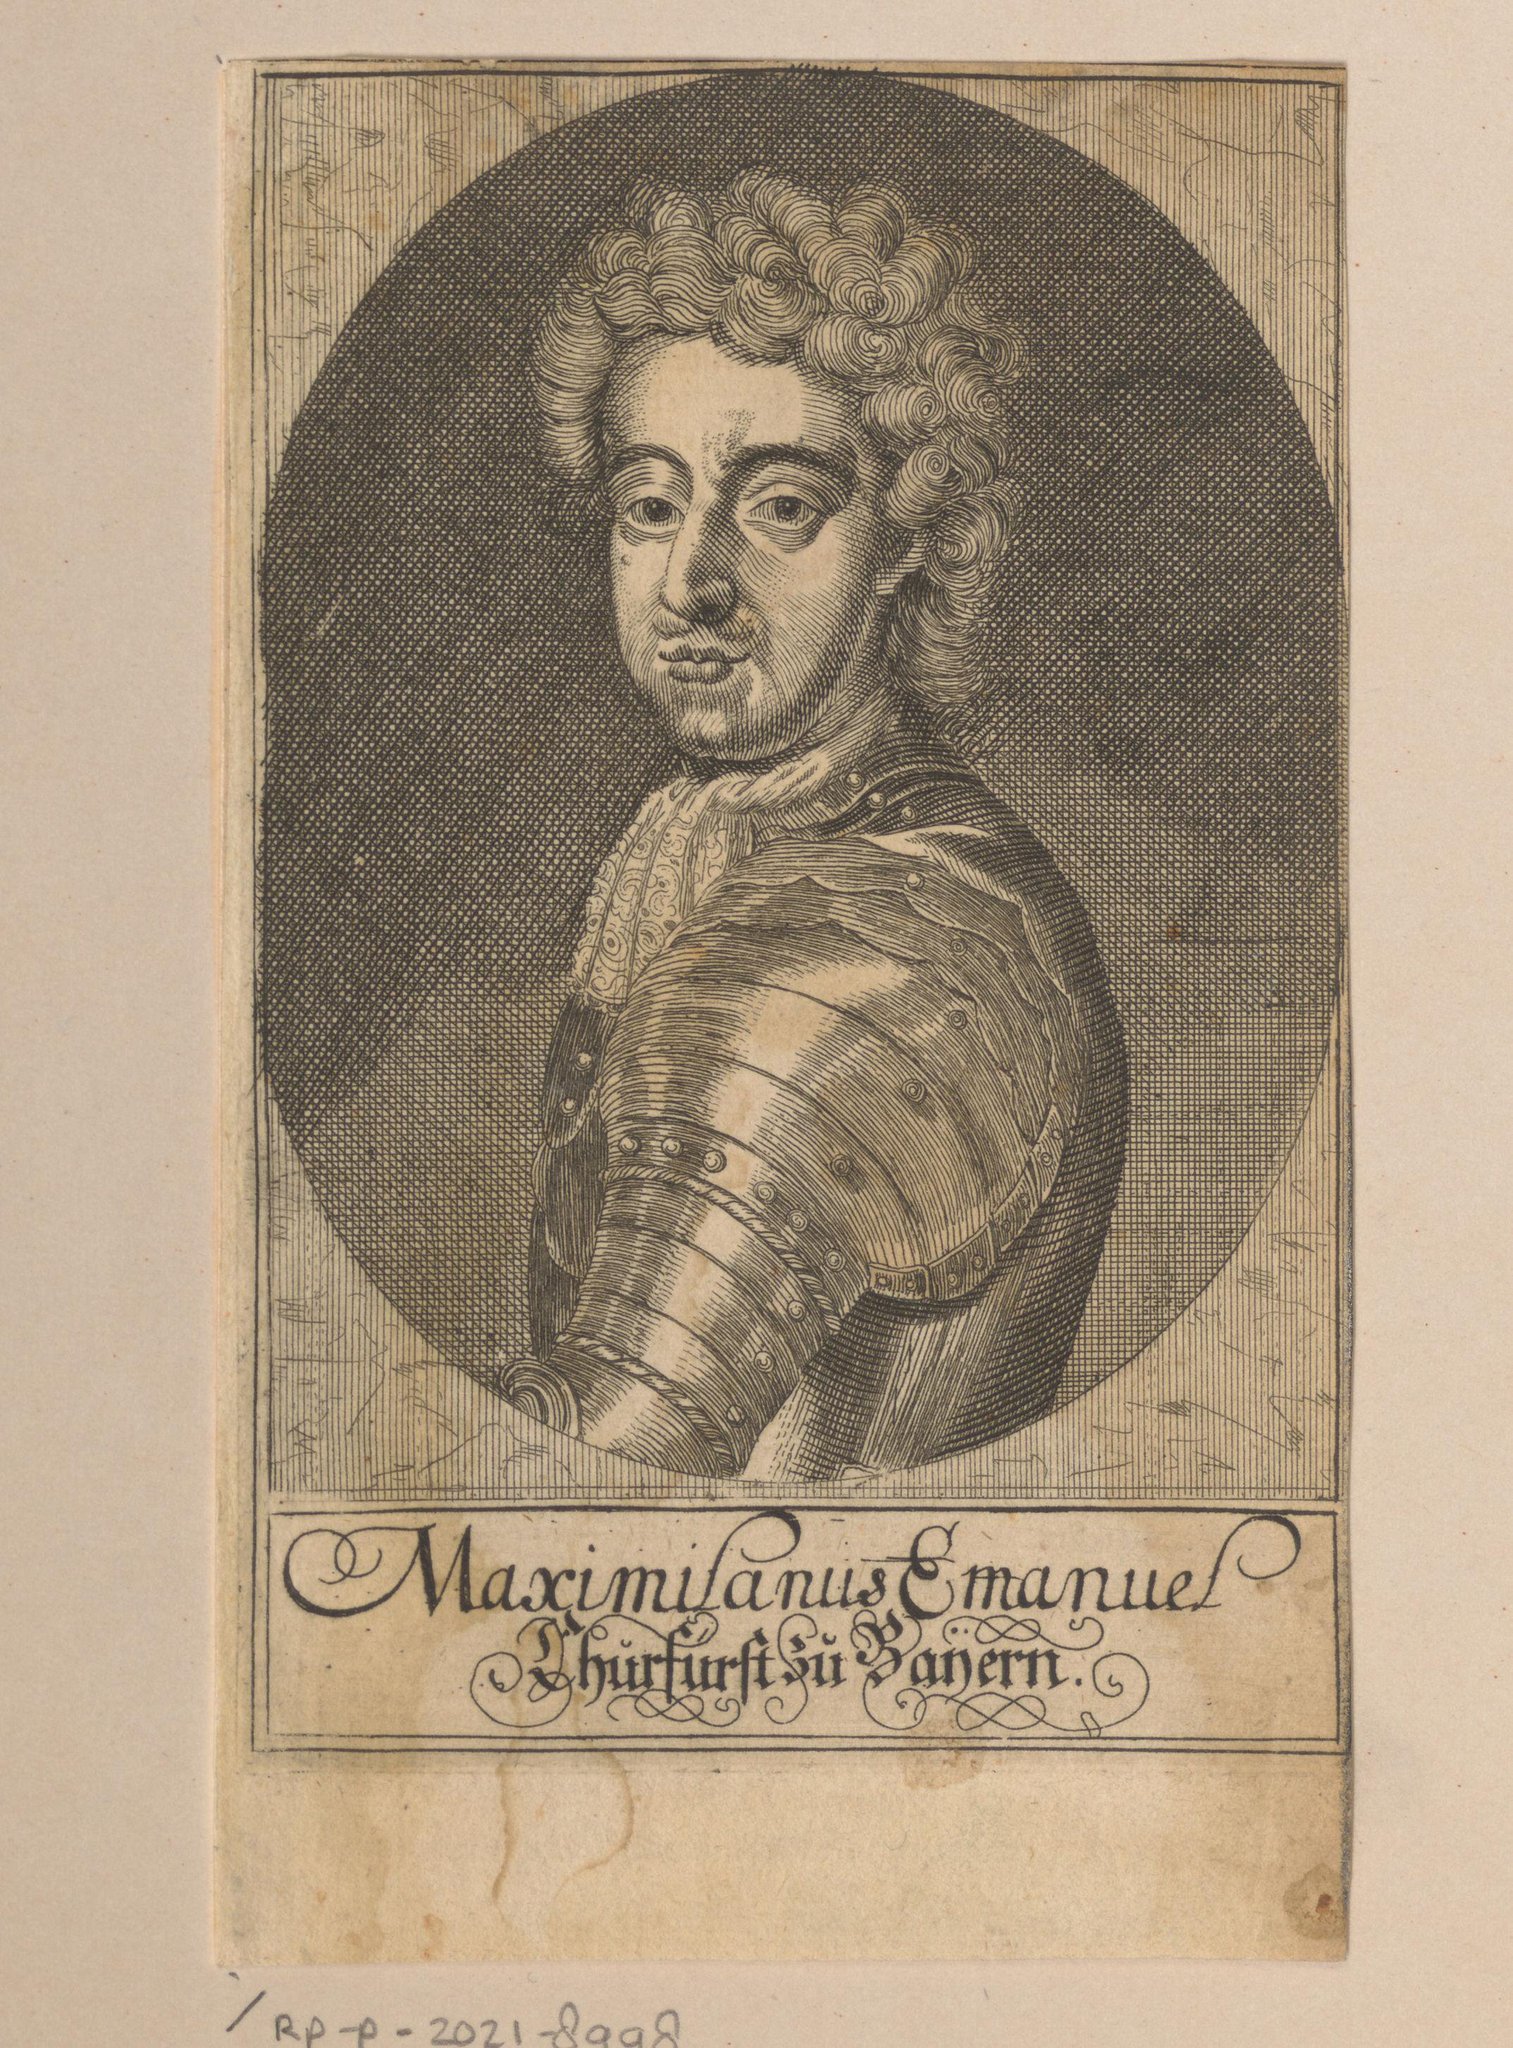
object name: print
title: Portret van Maximiliaan II Emanuel van Beieren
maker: Anonymous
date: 1679-1720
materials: paper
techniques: engraving, etching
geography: germany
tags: maximiliaan ii emanuel (keurvorst van beieren), armour, historical persons